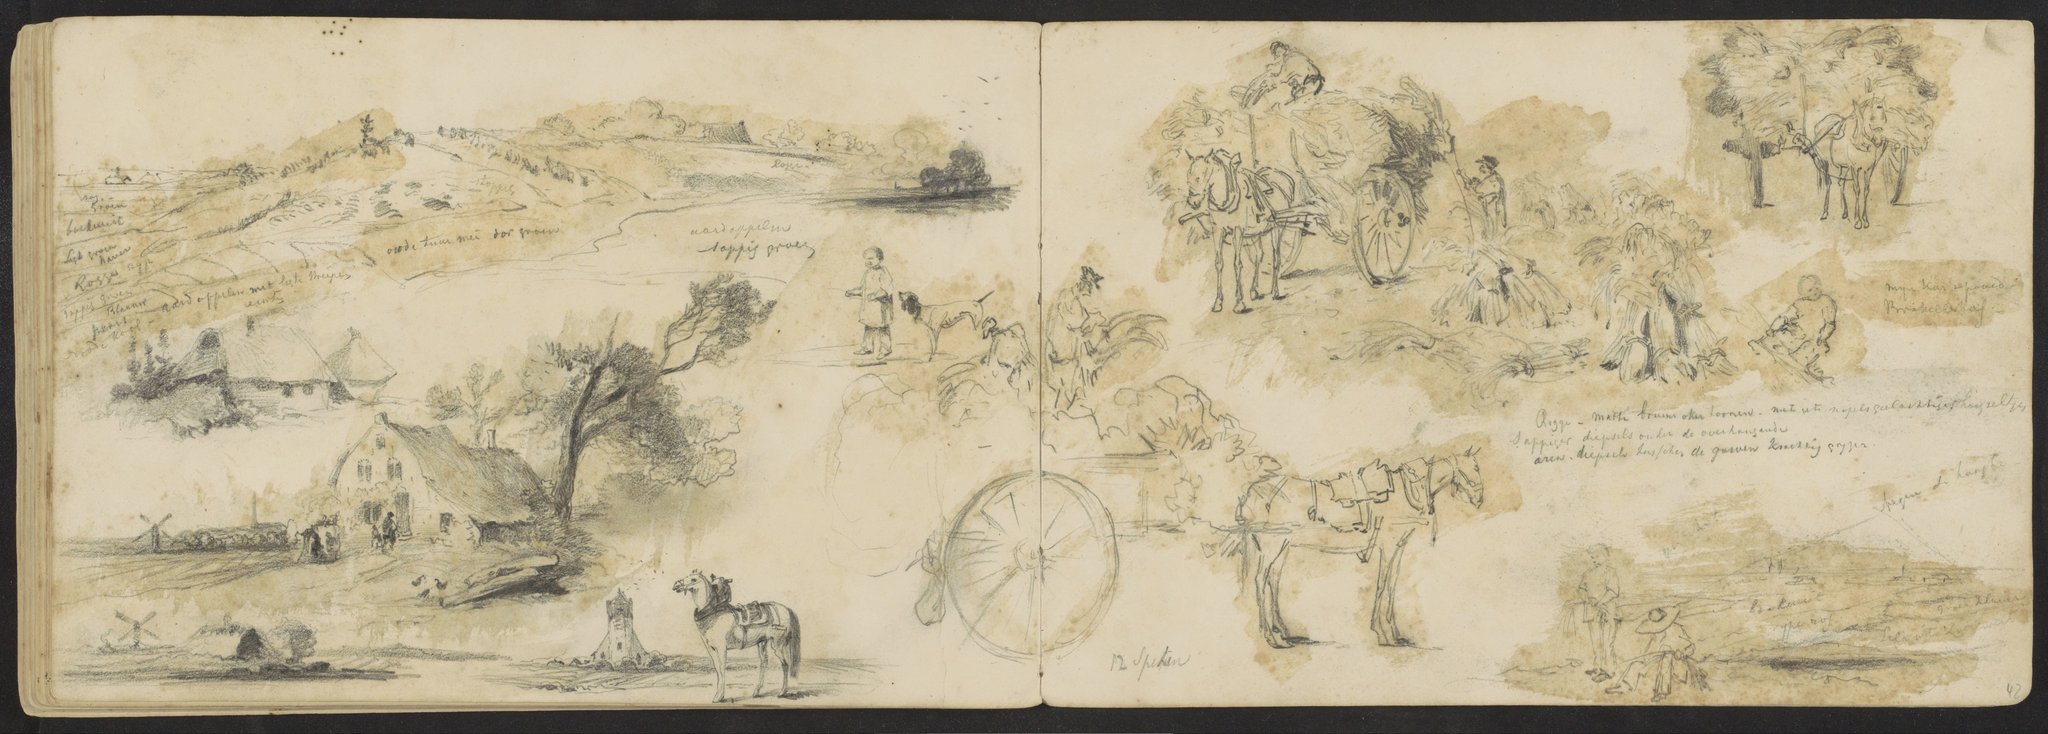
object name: sketchbook leaf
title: Studieblad, onder andere met landschappen, boerderijen en paarden met hooiwagens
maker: johannes tavenraat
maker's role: draughtsman, painter, print maker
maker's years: 1809-1881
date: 1842-1868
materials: paper, pencil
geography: materborn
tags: city-view, and landscape with man-made constructions, landscapes, rural housing, e.g. country-house, villa, cottage, hay-wagon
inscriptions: annotation: ‘mijn kar en paard/ Brakellshof’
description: Blad 41 verso en 42 recto in een schetsboek met 45 bladen.